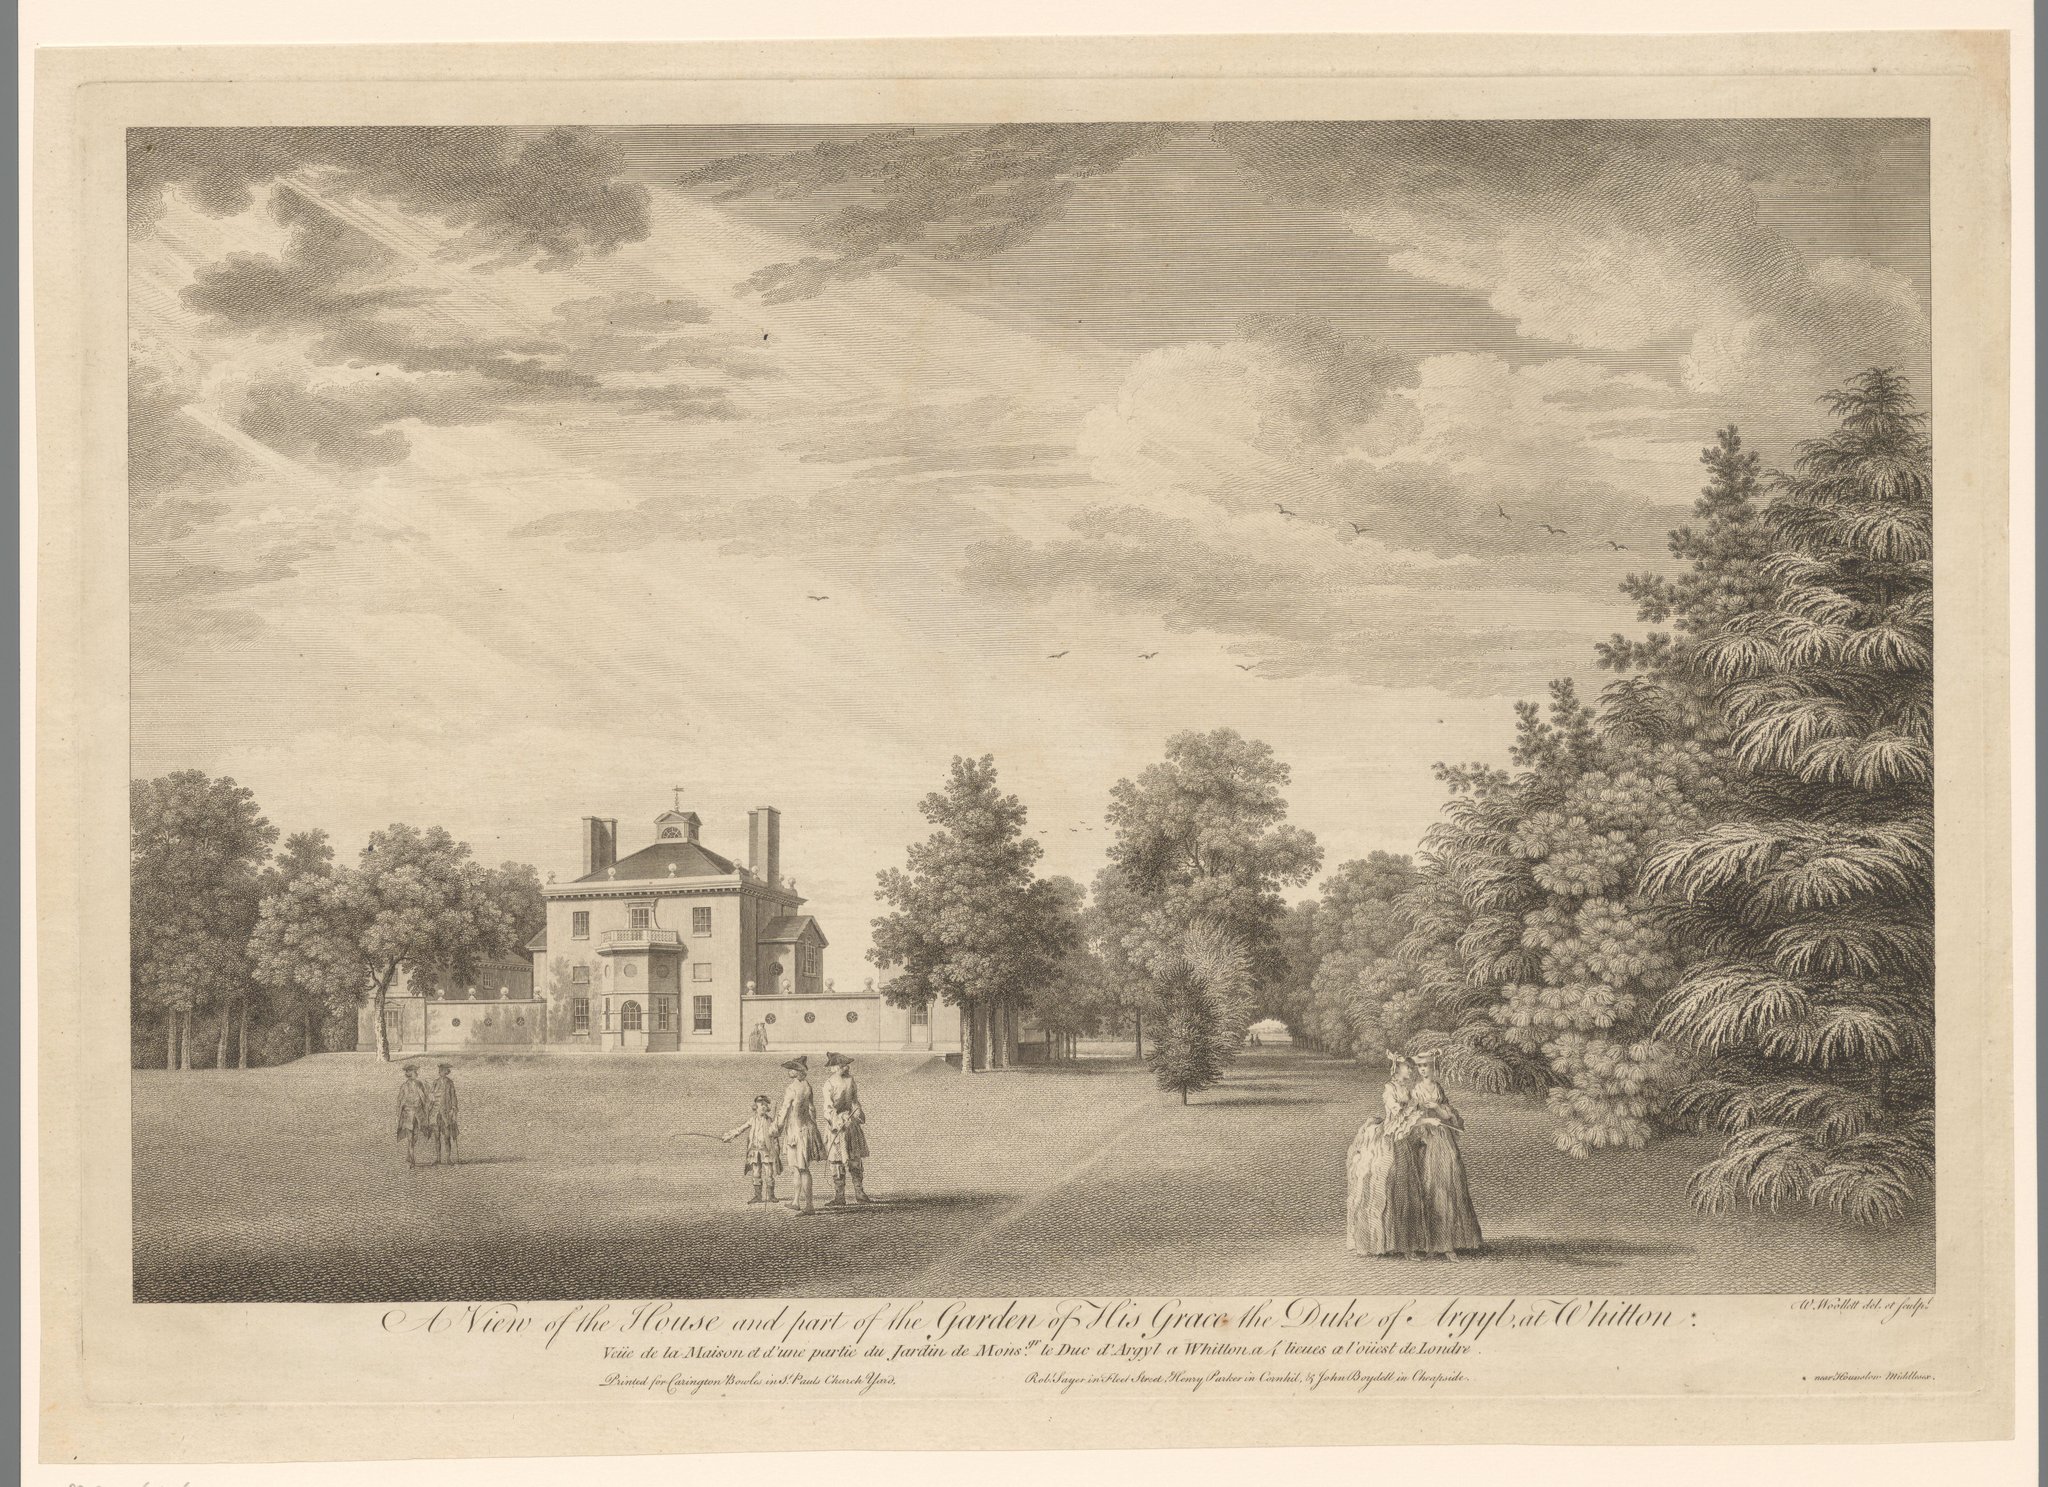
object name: print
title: Gezicht op het landhuis en de tuin van Whitton Park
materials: paper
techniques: etching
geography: london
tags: country-house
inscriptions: collector's mark: Lugt 2228